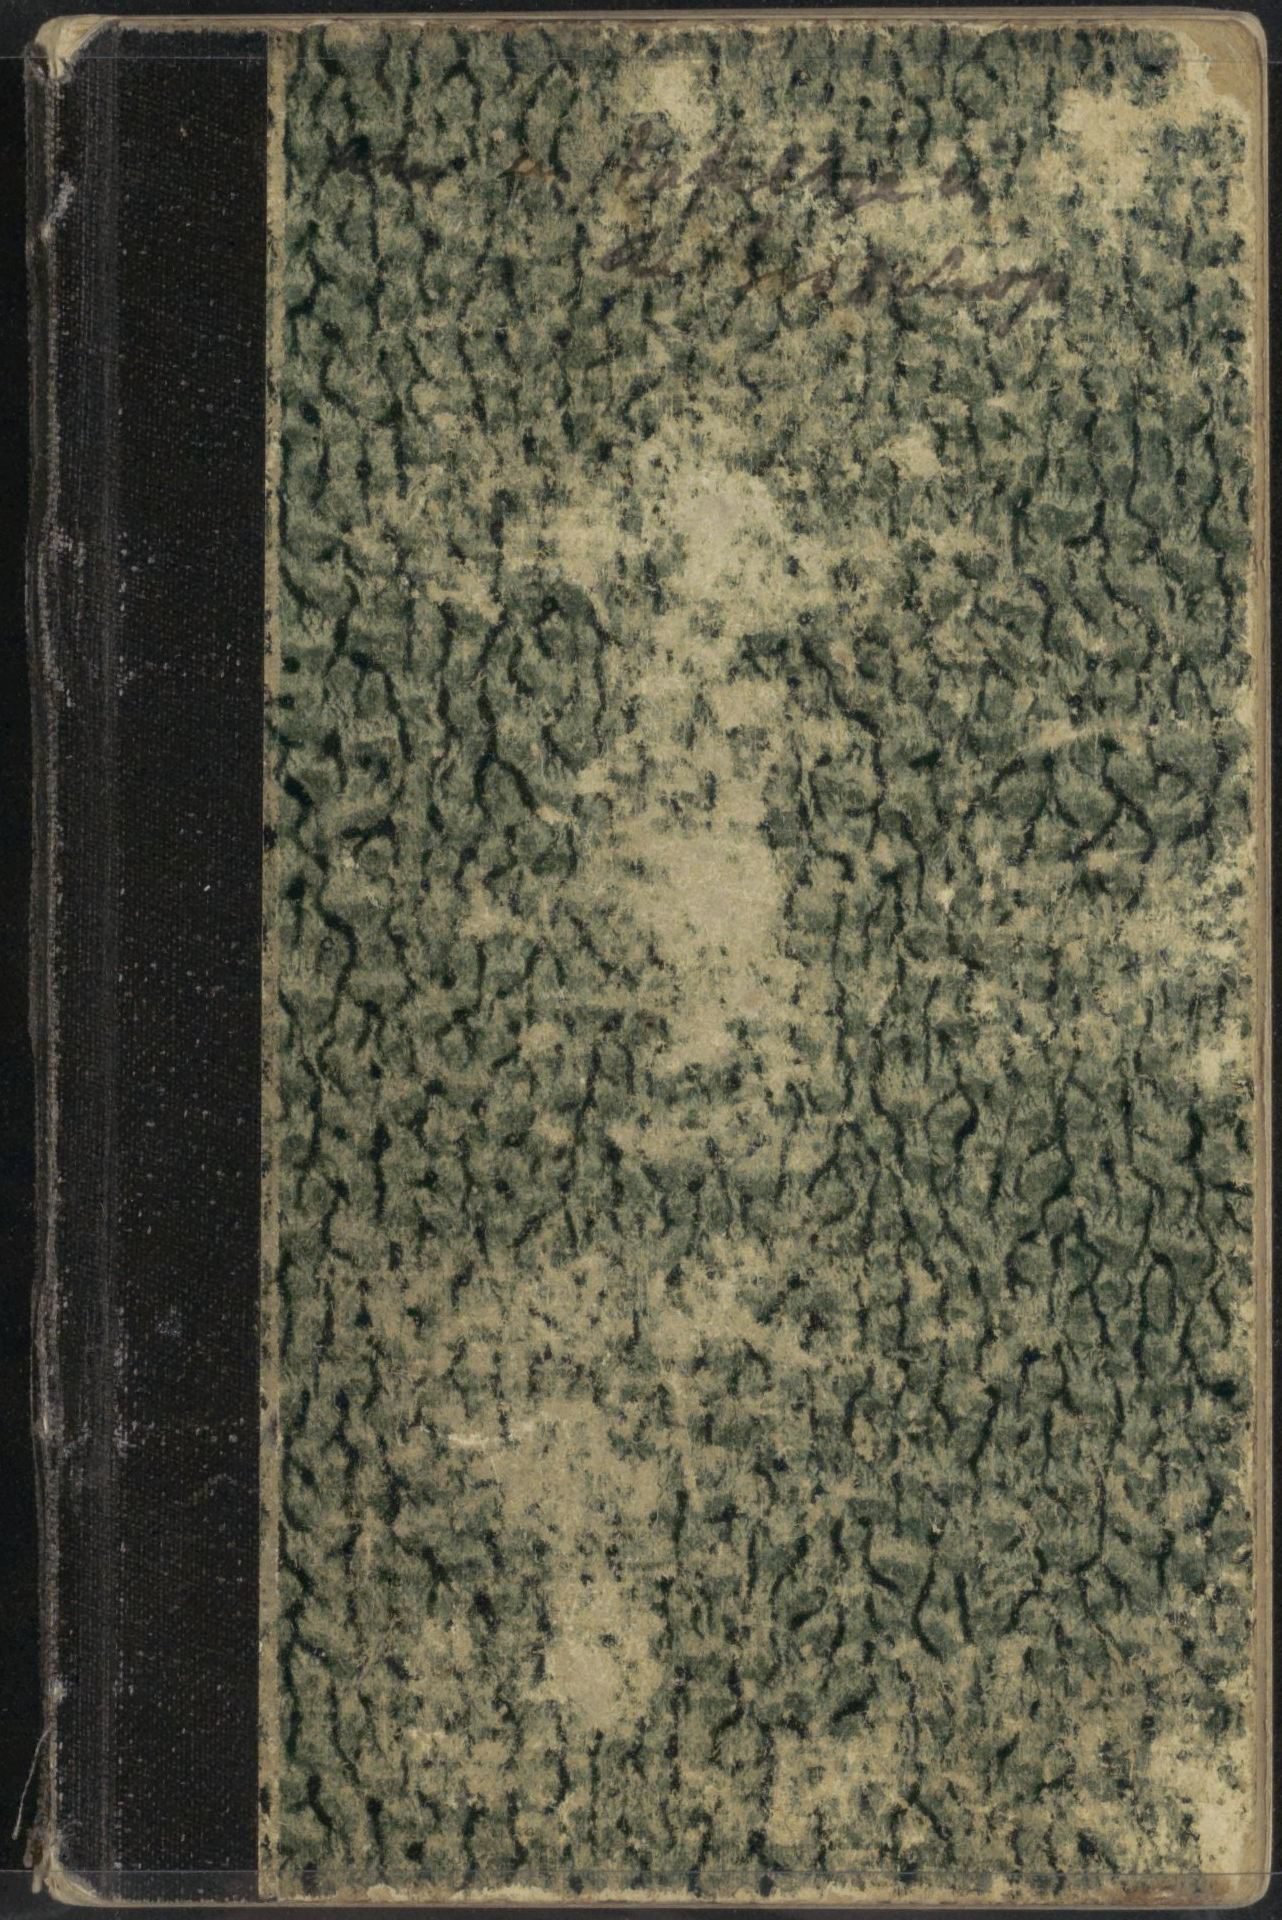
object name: sketchbook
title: Schetsboek met 46 bladen vervaardigd te Noord-Holland en Utrecht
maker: george hendrik breitner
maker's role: draughtsman, painter, print maker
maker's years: 1857-1923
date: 1902-1914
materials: chalk, paper, pencil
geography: utrecht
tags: landscapes, horse, street, haarlem, utrecht, amsterdam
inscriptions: retailer's mark: ‘Gebrs. Simons/ Amsterdam./ Filiaal/ Heiligenweg 34/ Kantoorboek & Papierhandel./ Linieer- en Perforeer-inrichting./ No. 141 Blanco/ Bij nabestelling van dit boek, gelieve men/ bovenstaand nummer op te geven. / per doz f 1.60 per stuk 15’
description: Schetsboek bestaande uit 46 bladen met gezichten te Amsterdam, Utrecht, Haarlem en Aerdenhout. Verder paarden.